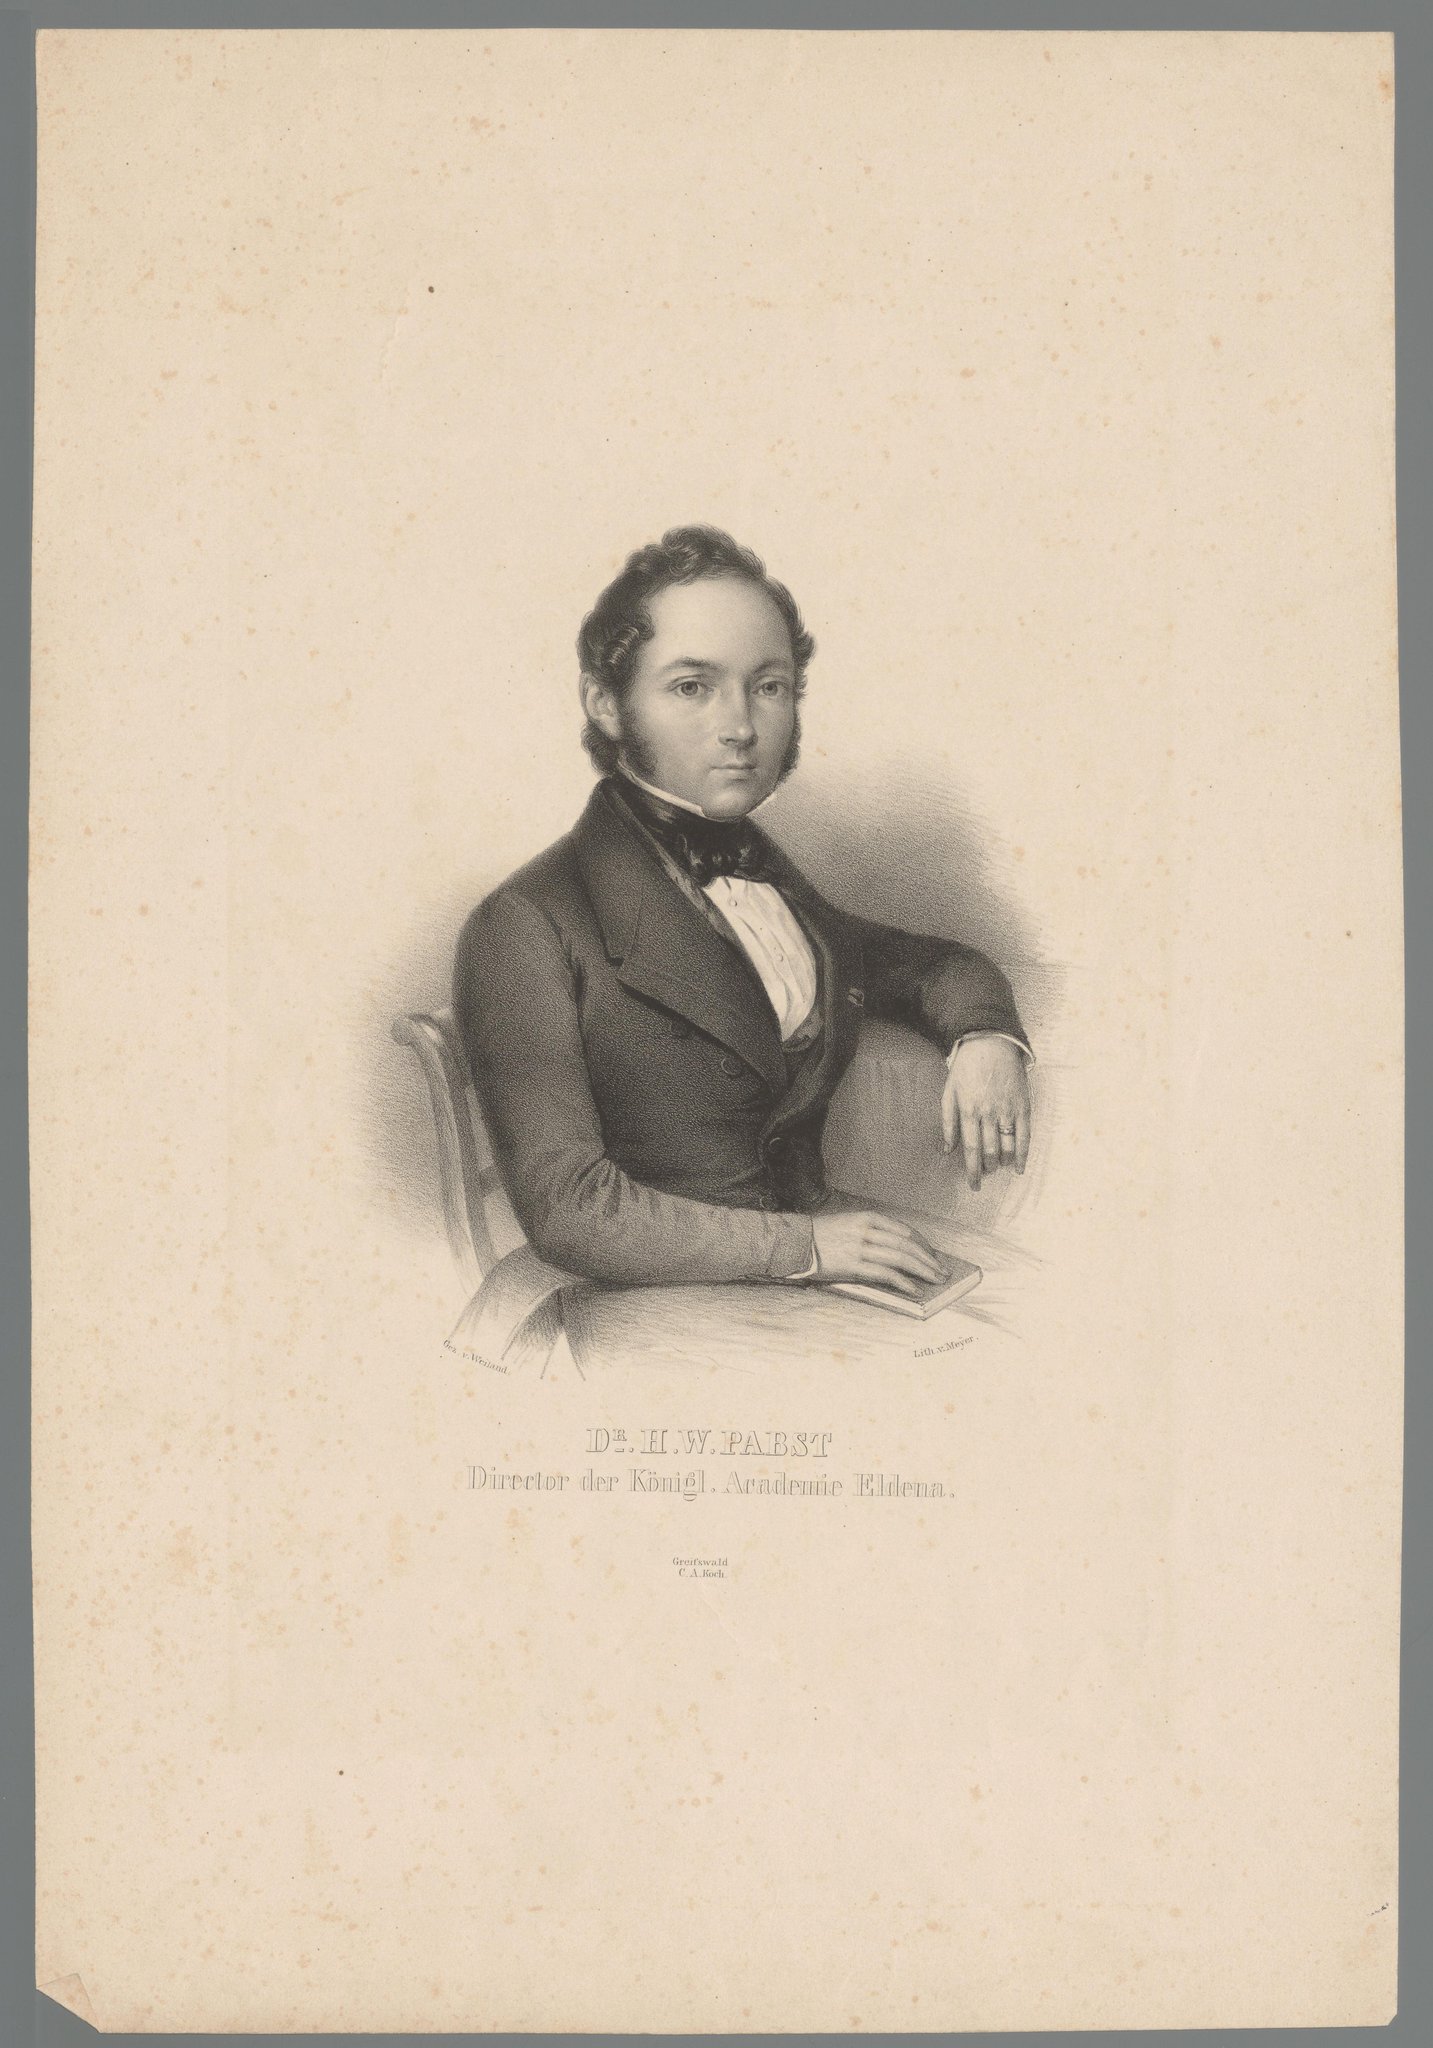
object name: print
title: Dr. H.W. Pabst, Director der Königl. Academie Eldena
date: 1820-1850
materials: paper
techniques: lithograph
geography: greifswald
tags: adult man, historical persons, book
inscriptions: collector's mark: Lugt 2228